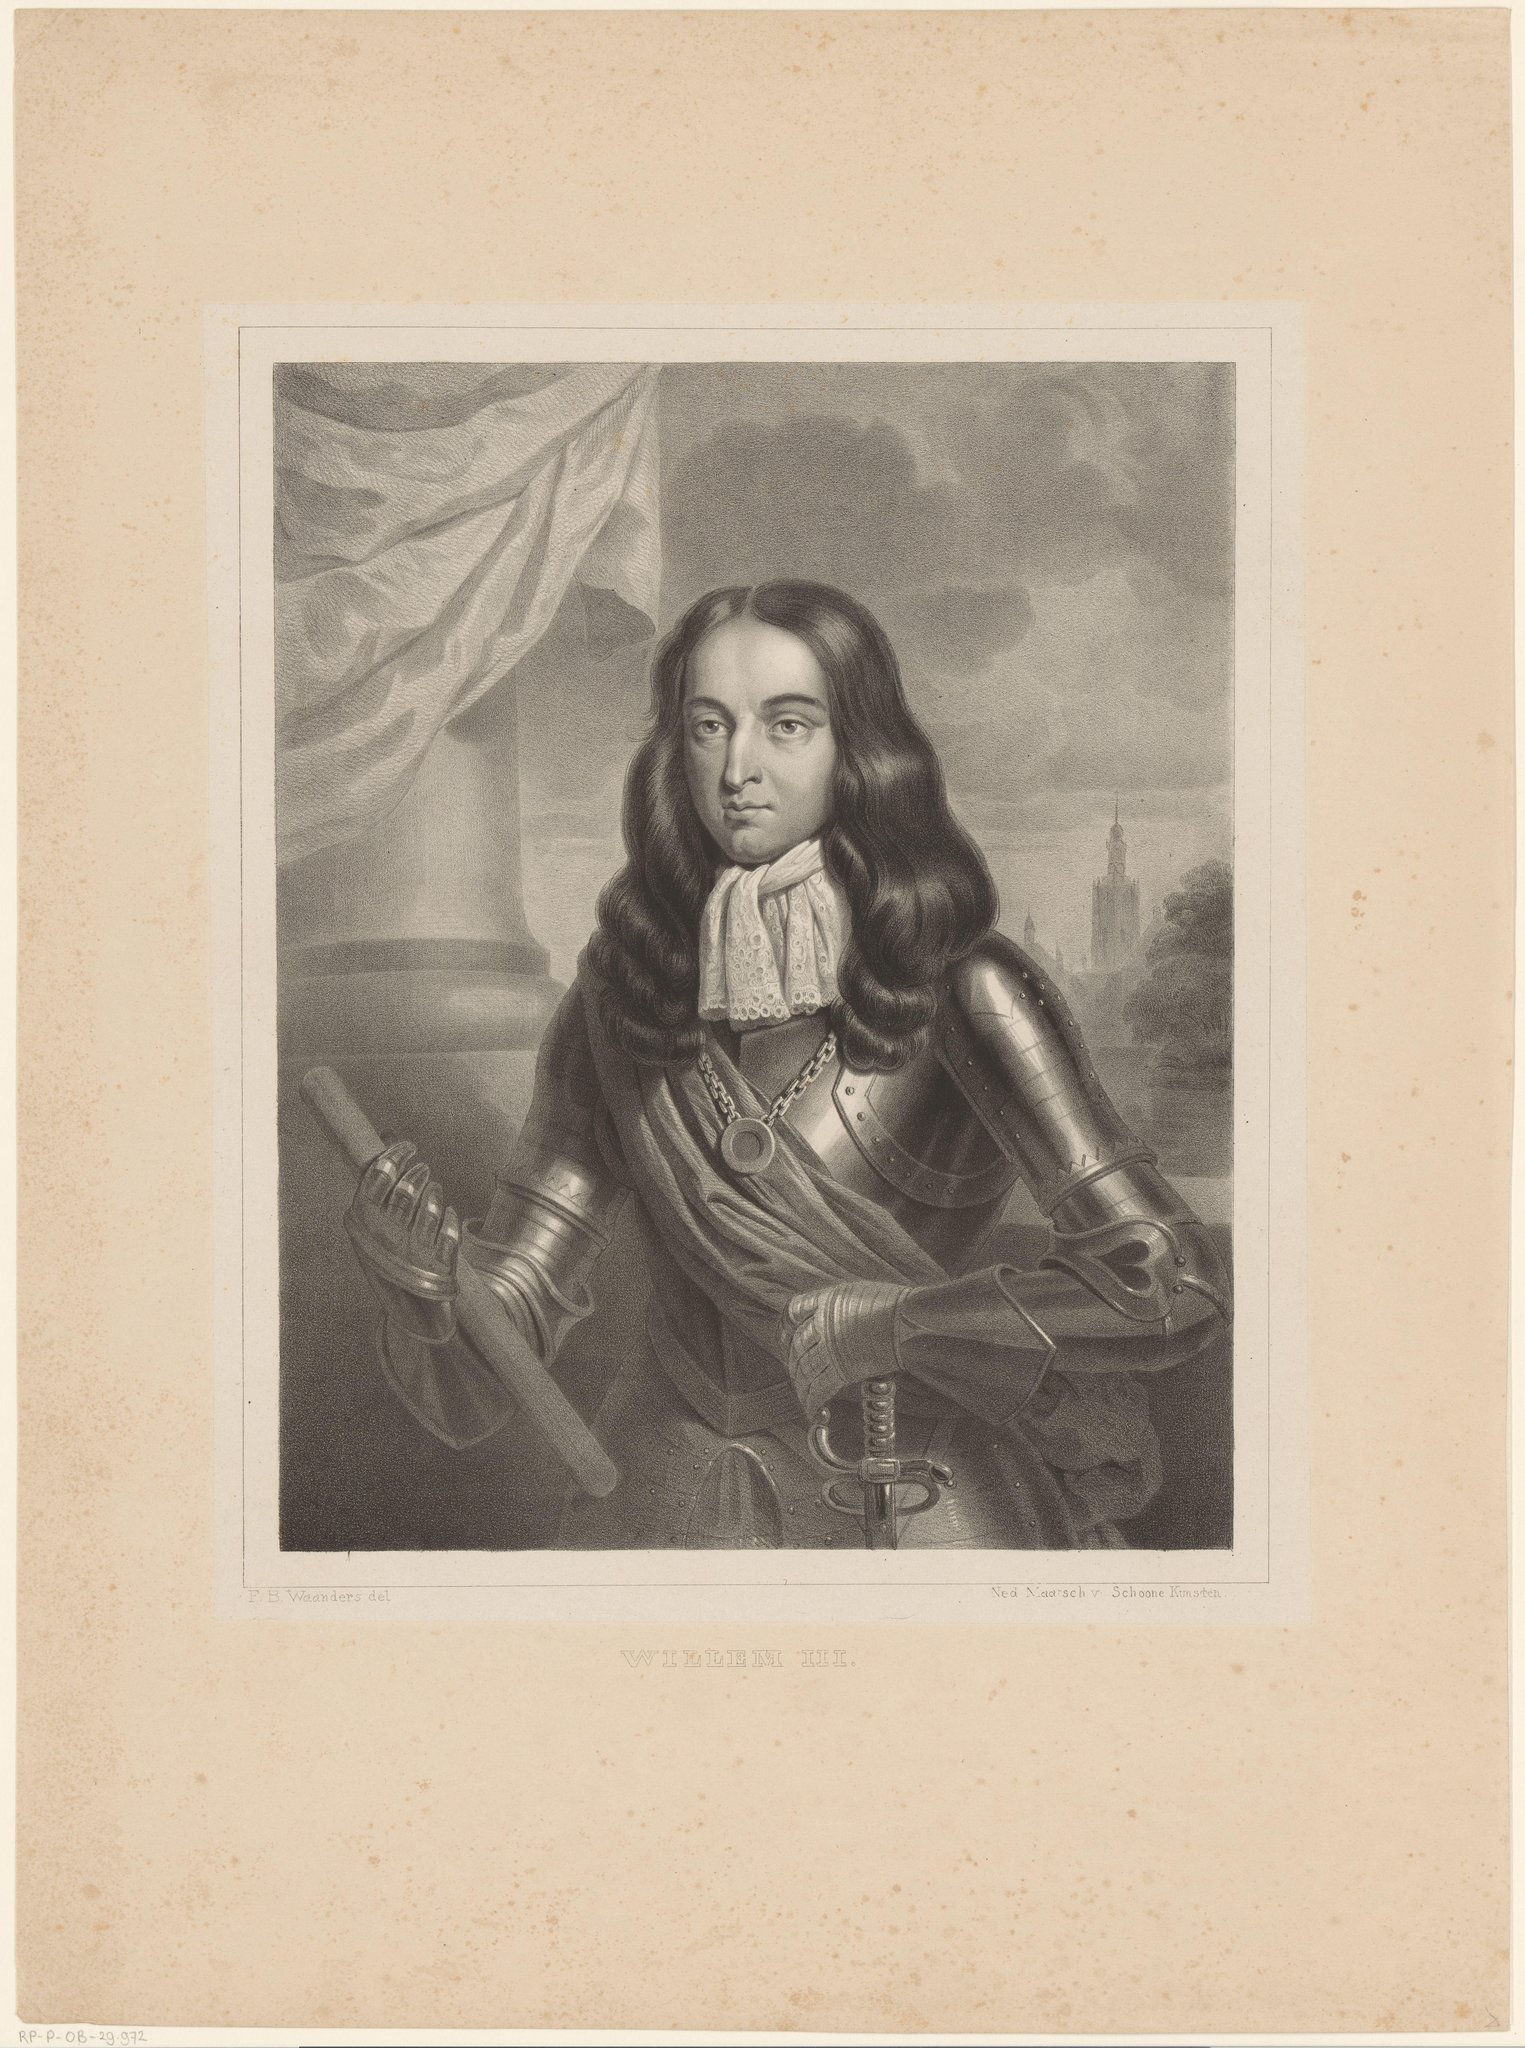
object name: print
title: Willem III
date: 1840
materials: paper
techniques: lithograph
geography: the hague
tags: the hague, william iii (prince of orange and king of england, scotland, and ireland), historical persons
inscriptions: collector's mark: Lugt 2228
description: Deze prent was onderdeel van: Valhalla : galerij van vermaarde Nederlandsche mannen: geschiedkundige portretten door de voornaamste Nederlandsche kunstenaars geteekend: met beschrijving. Den Haag: Nederlandsche Maatschappij voor Schoone Kunsten, 1840.